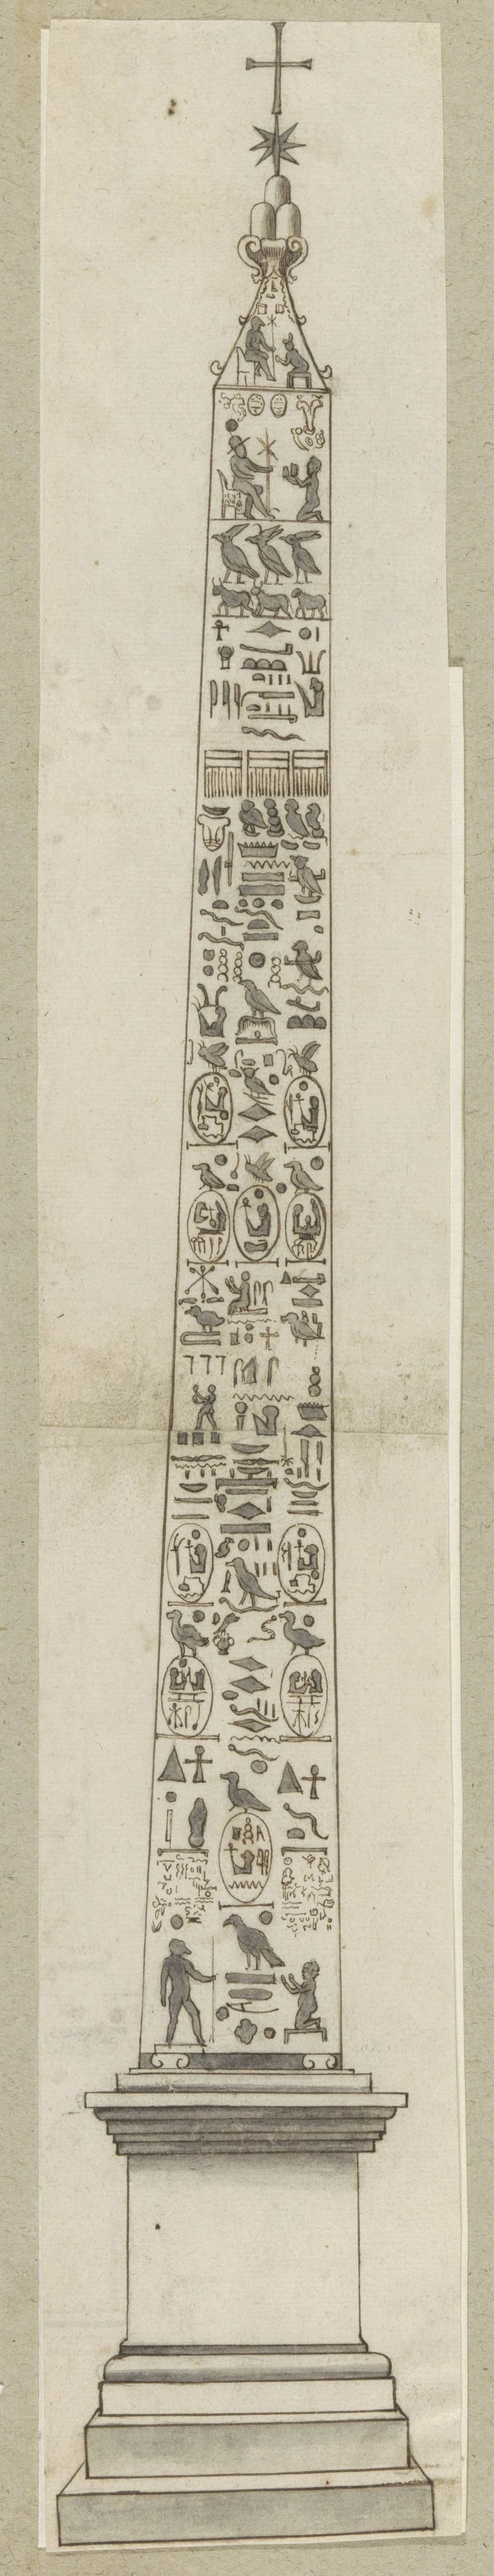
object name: album leaf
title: Egyptische obelisk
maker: Anonymous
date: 1550-1650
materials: ink, paper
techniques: brush, pen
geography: italy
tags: obelisk, needle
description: De tekening maakt deel uit van een album.